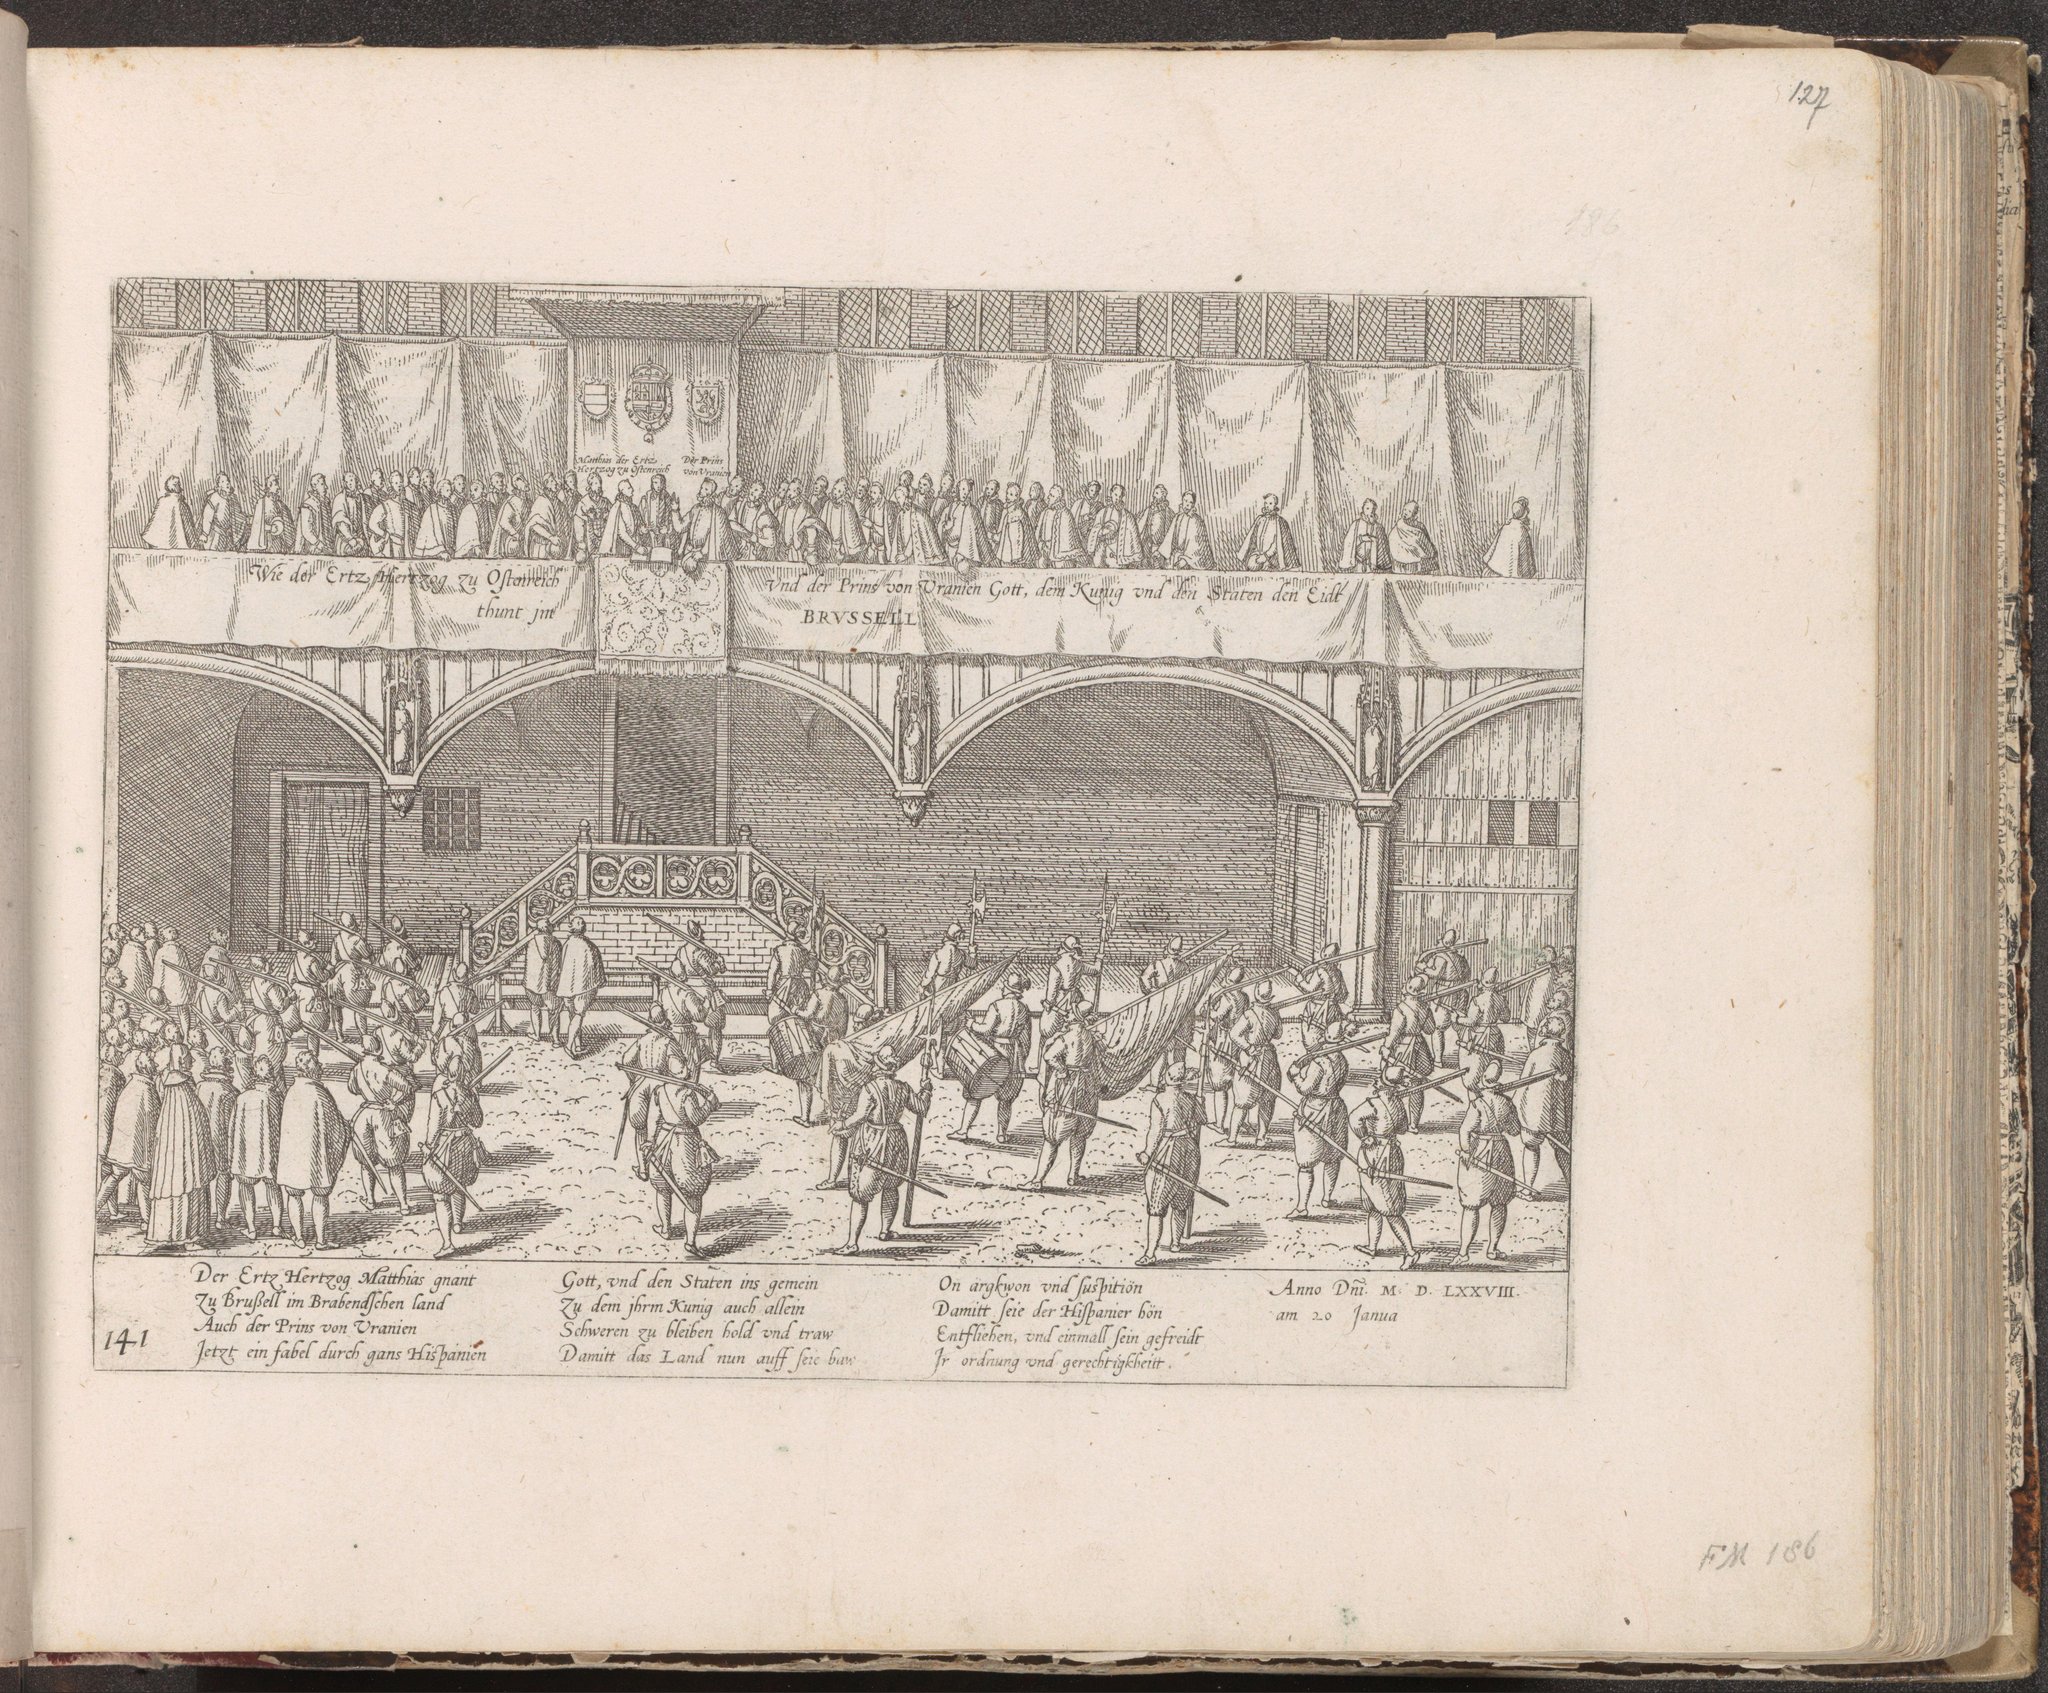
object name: history print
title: Serie 8: Nederlandse Gebeurtenissen, 1577-1583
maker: frans hogenberg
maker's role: print maker, publisher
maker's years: 1538-1590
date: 1581-1585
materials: paper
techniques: etching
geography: cologne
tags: vienna, matthias van oostenrijk (rooms-duits keizer), delft, william i (prince of orange), new ruler taking the oath, brussels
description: Matthias legt te Brussel de eed als landvoogd af, 1578. De prins neemt met opgeheven hand de aartshertog met de hand op een boek de eed af. Staande op een balkon tussen leden van de Staten-Generaal, beneden soldaten. Met onderschrift van 12 regels in het Duits. Linksonder genummerd: 141. De prent maakt deel uit van een album.